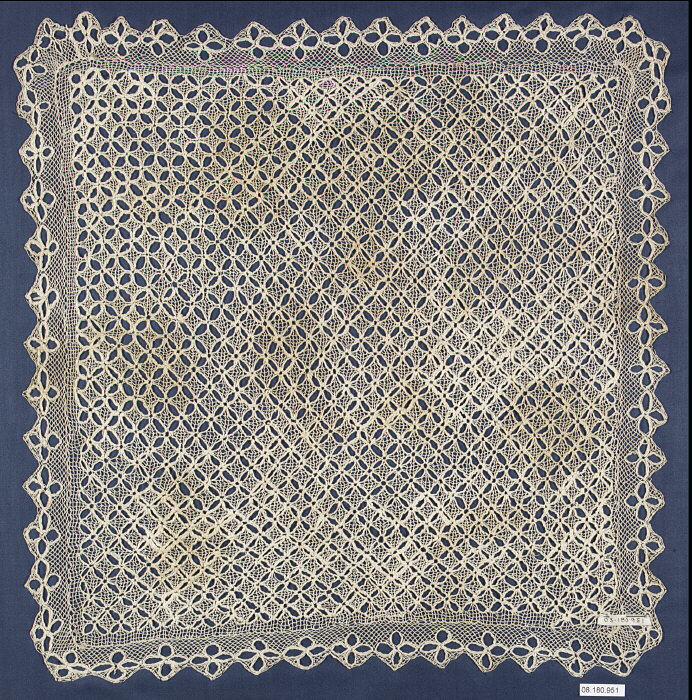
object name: square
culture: peruvian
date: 1801-1900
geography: peru